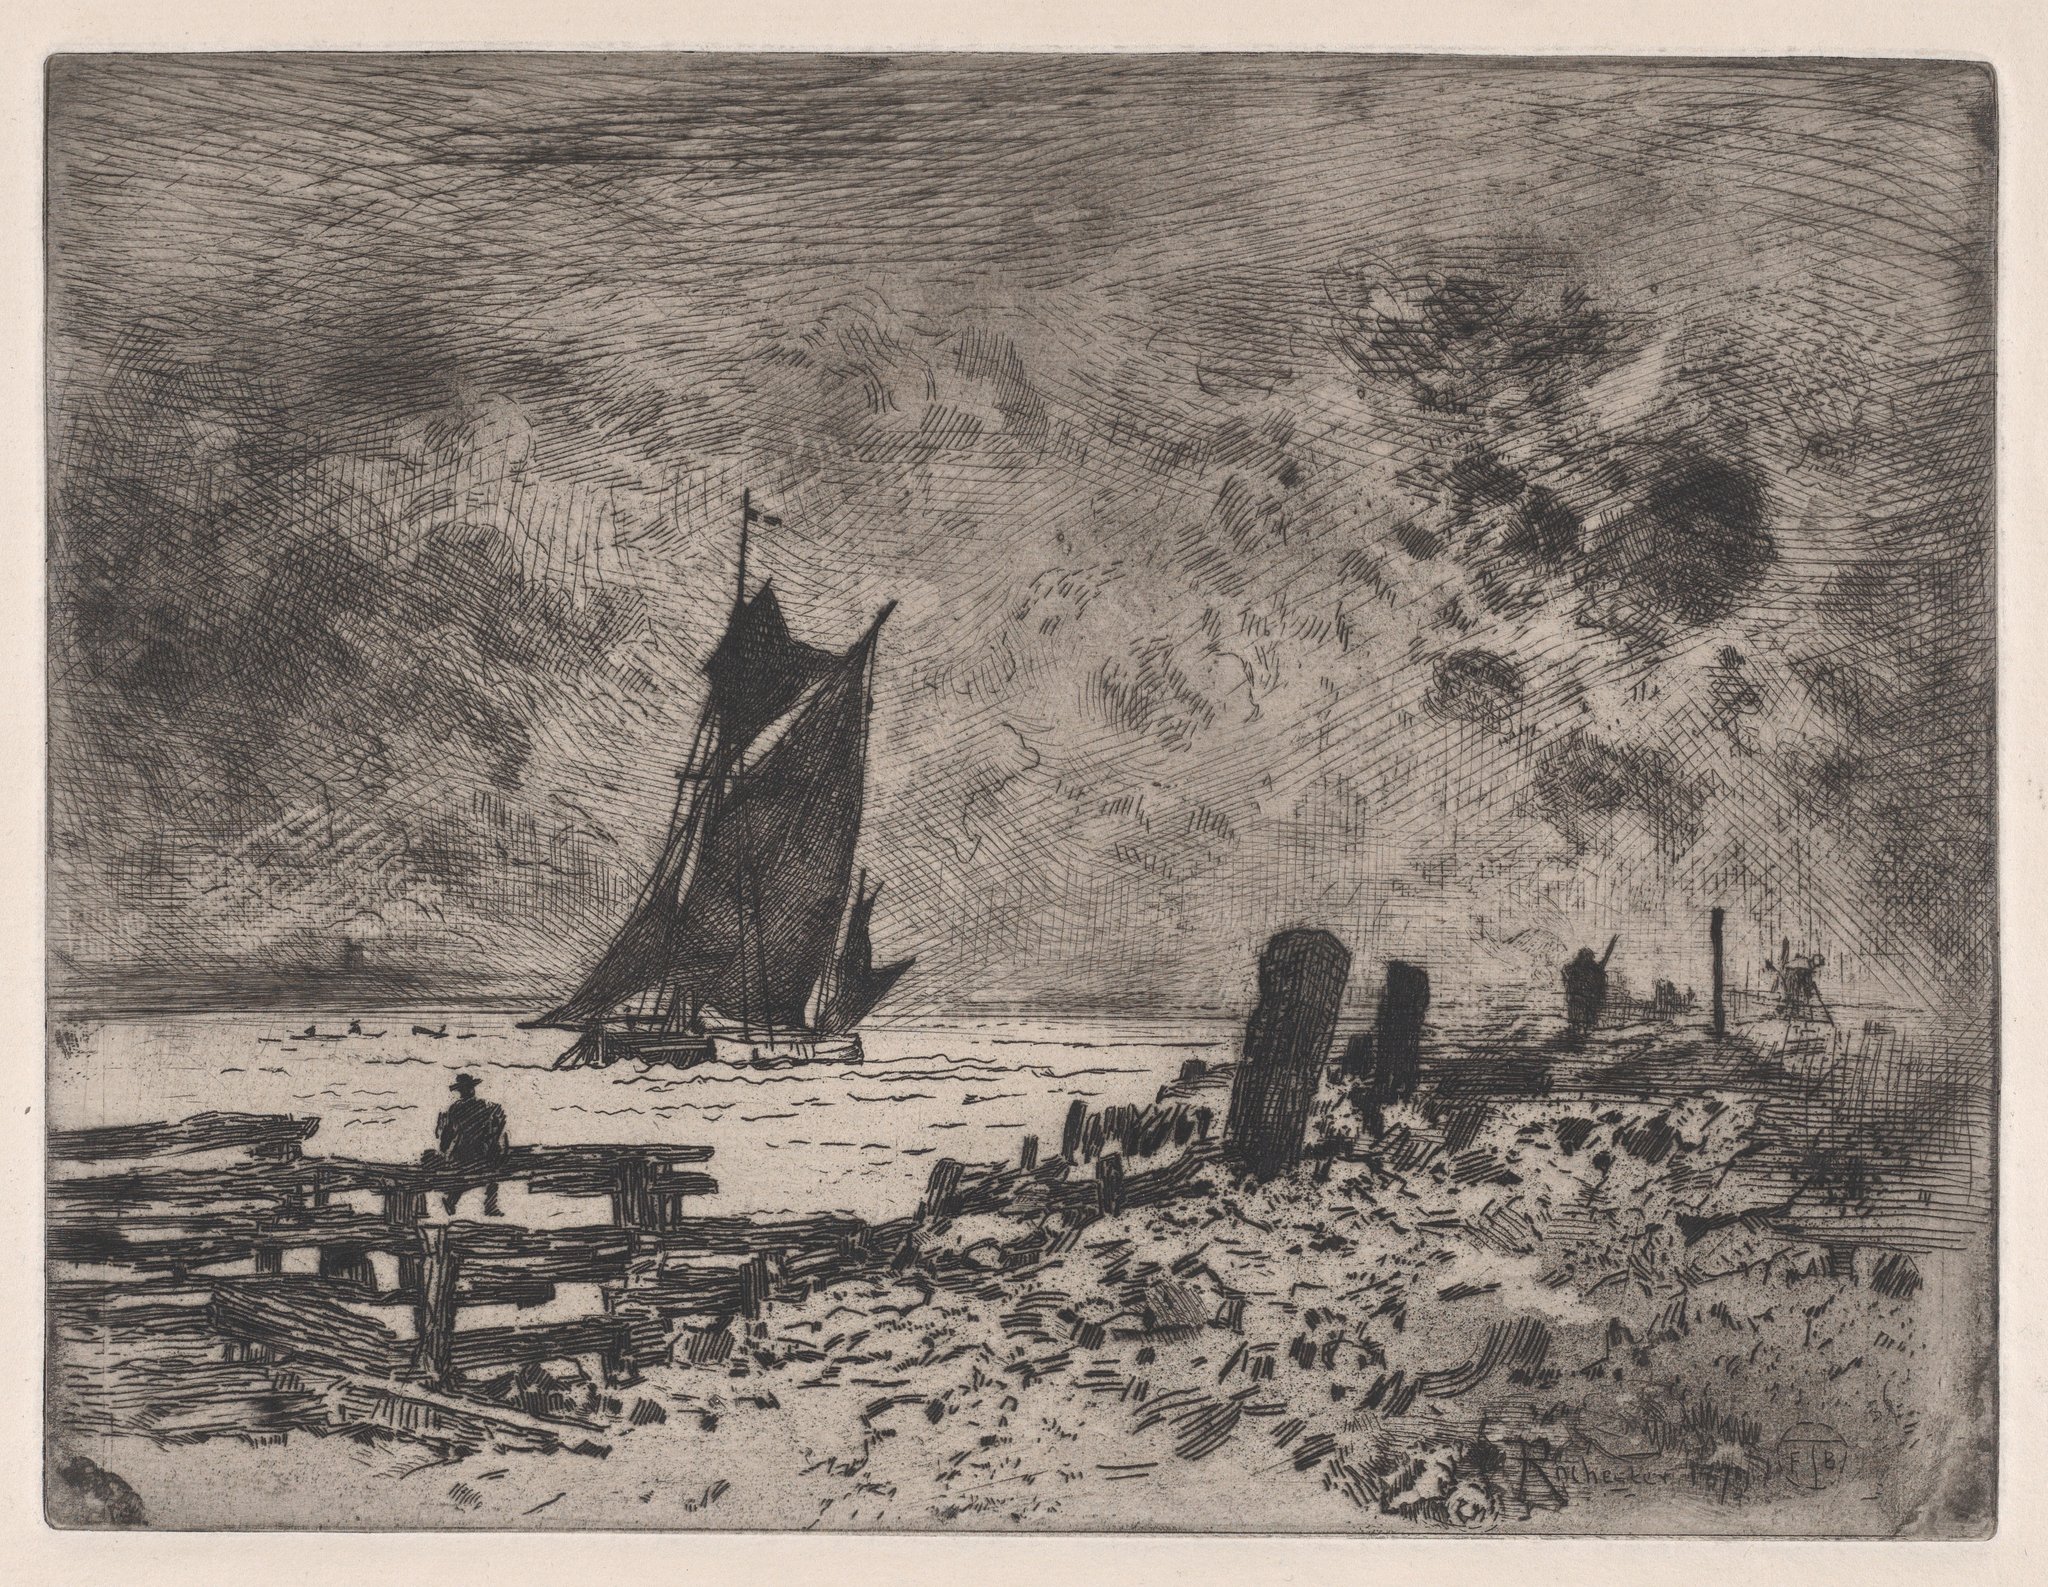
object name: print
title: The Little Marine - Souvenir of Medway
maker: félix-hilaire buhot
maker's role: artist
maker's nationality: french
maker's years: 1847-1898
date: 1879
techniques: aquatint, etching